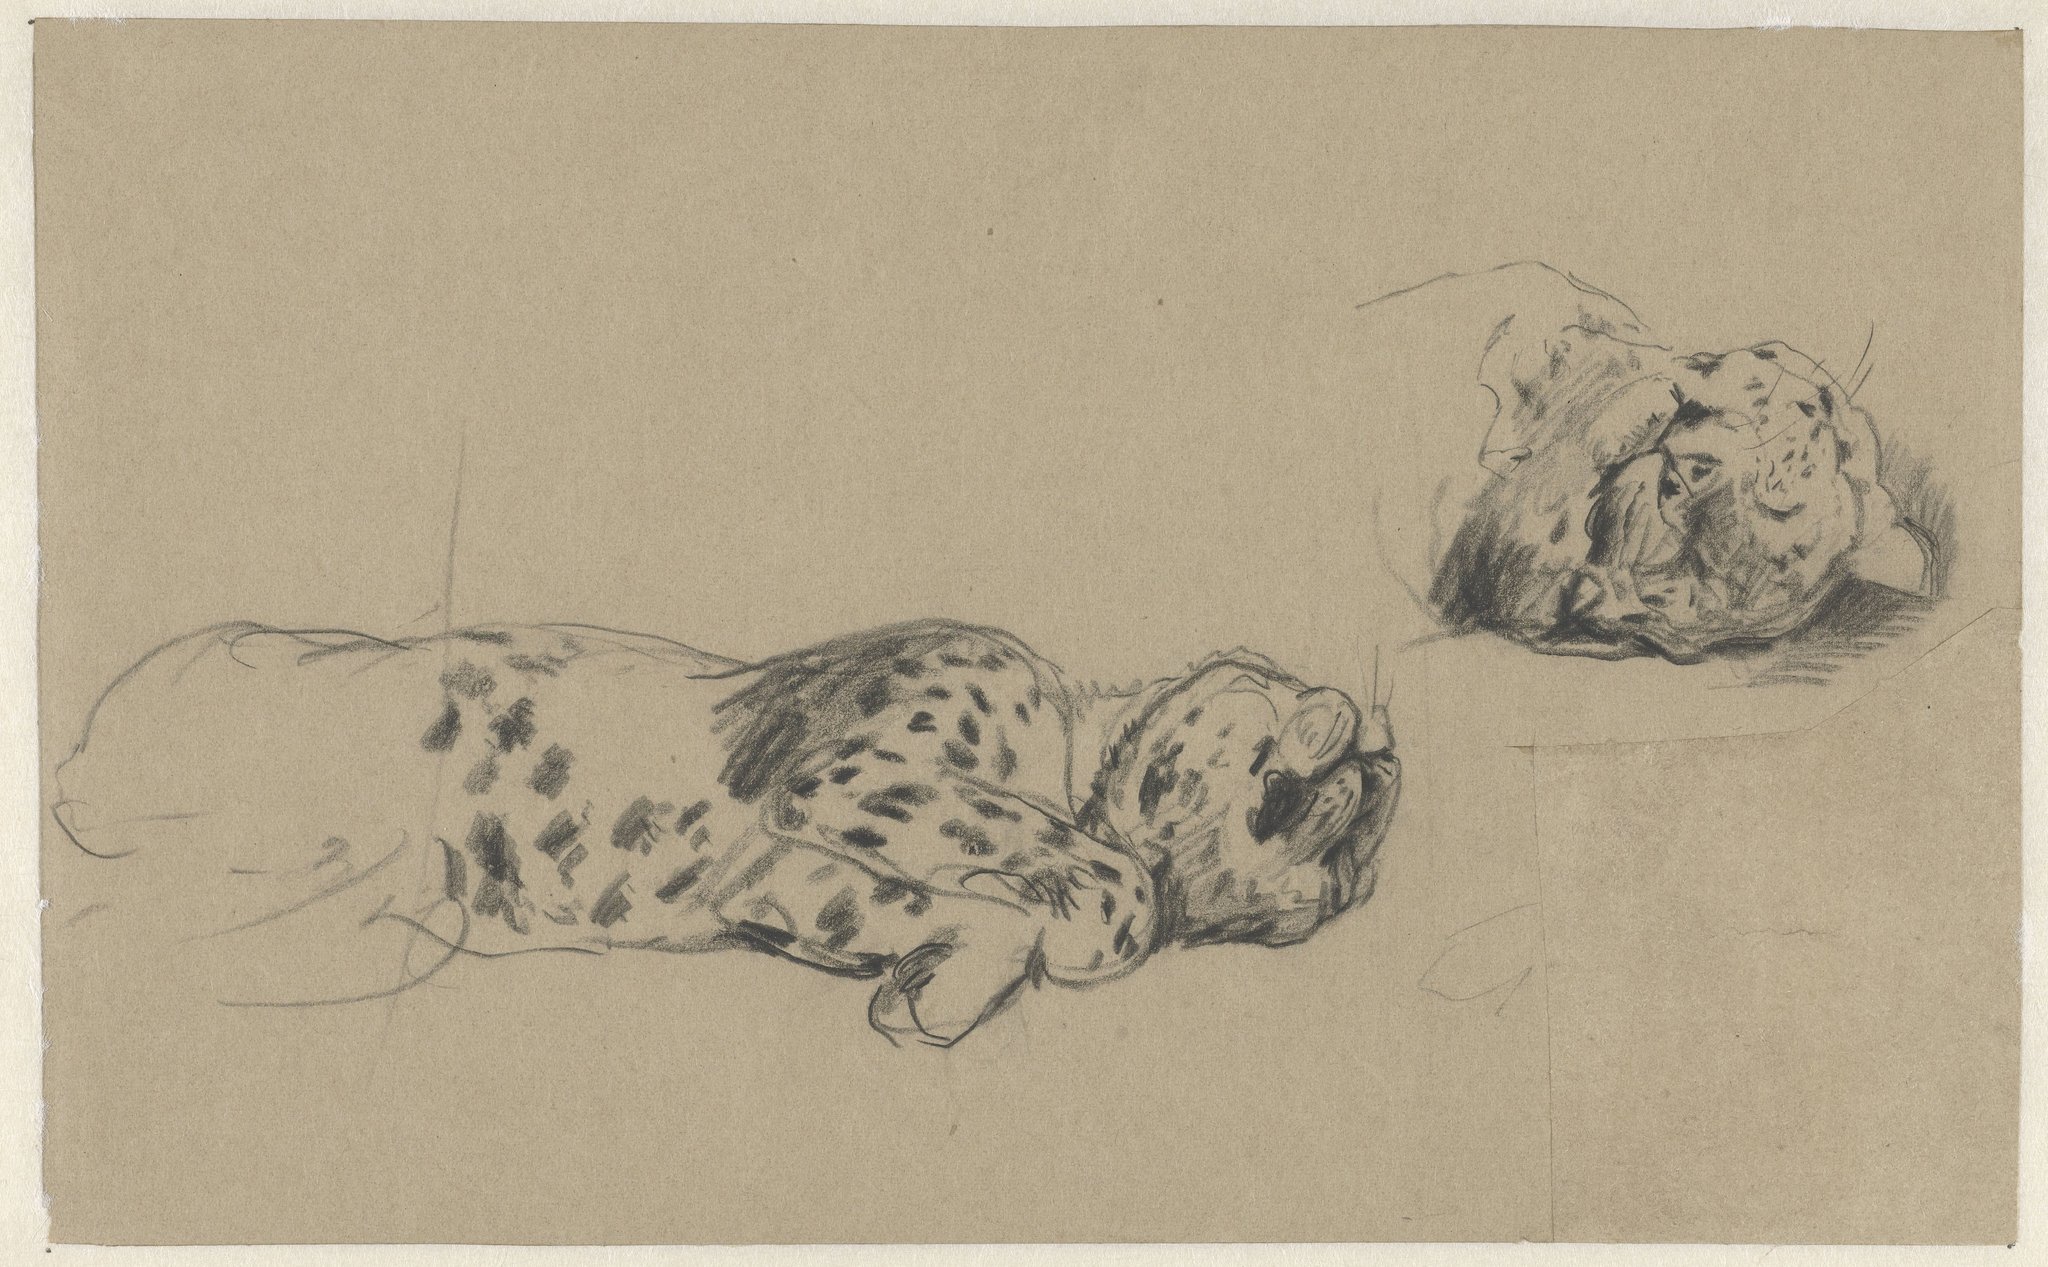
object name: drawing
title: Twee studies van een luipaard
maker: guillaume anne van der brugghen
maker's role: draughtsman, print maker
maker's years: 1812-1891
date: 1821-1891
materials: chalk, paper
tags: beasts of prey, predatory animals: leopard